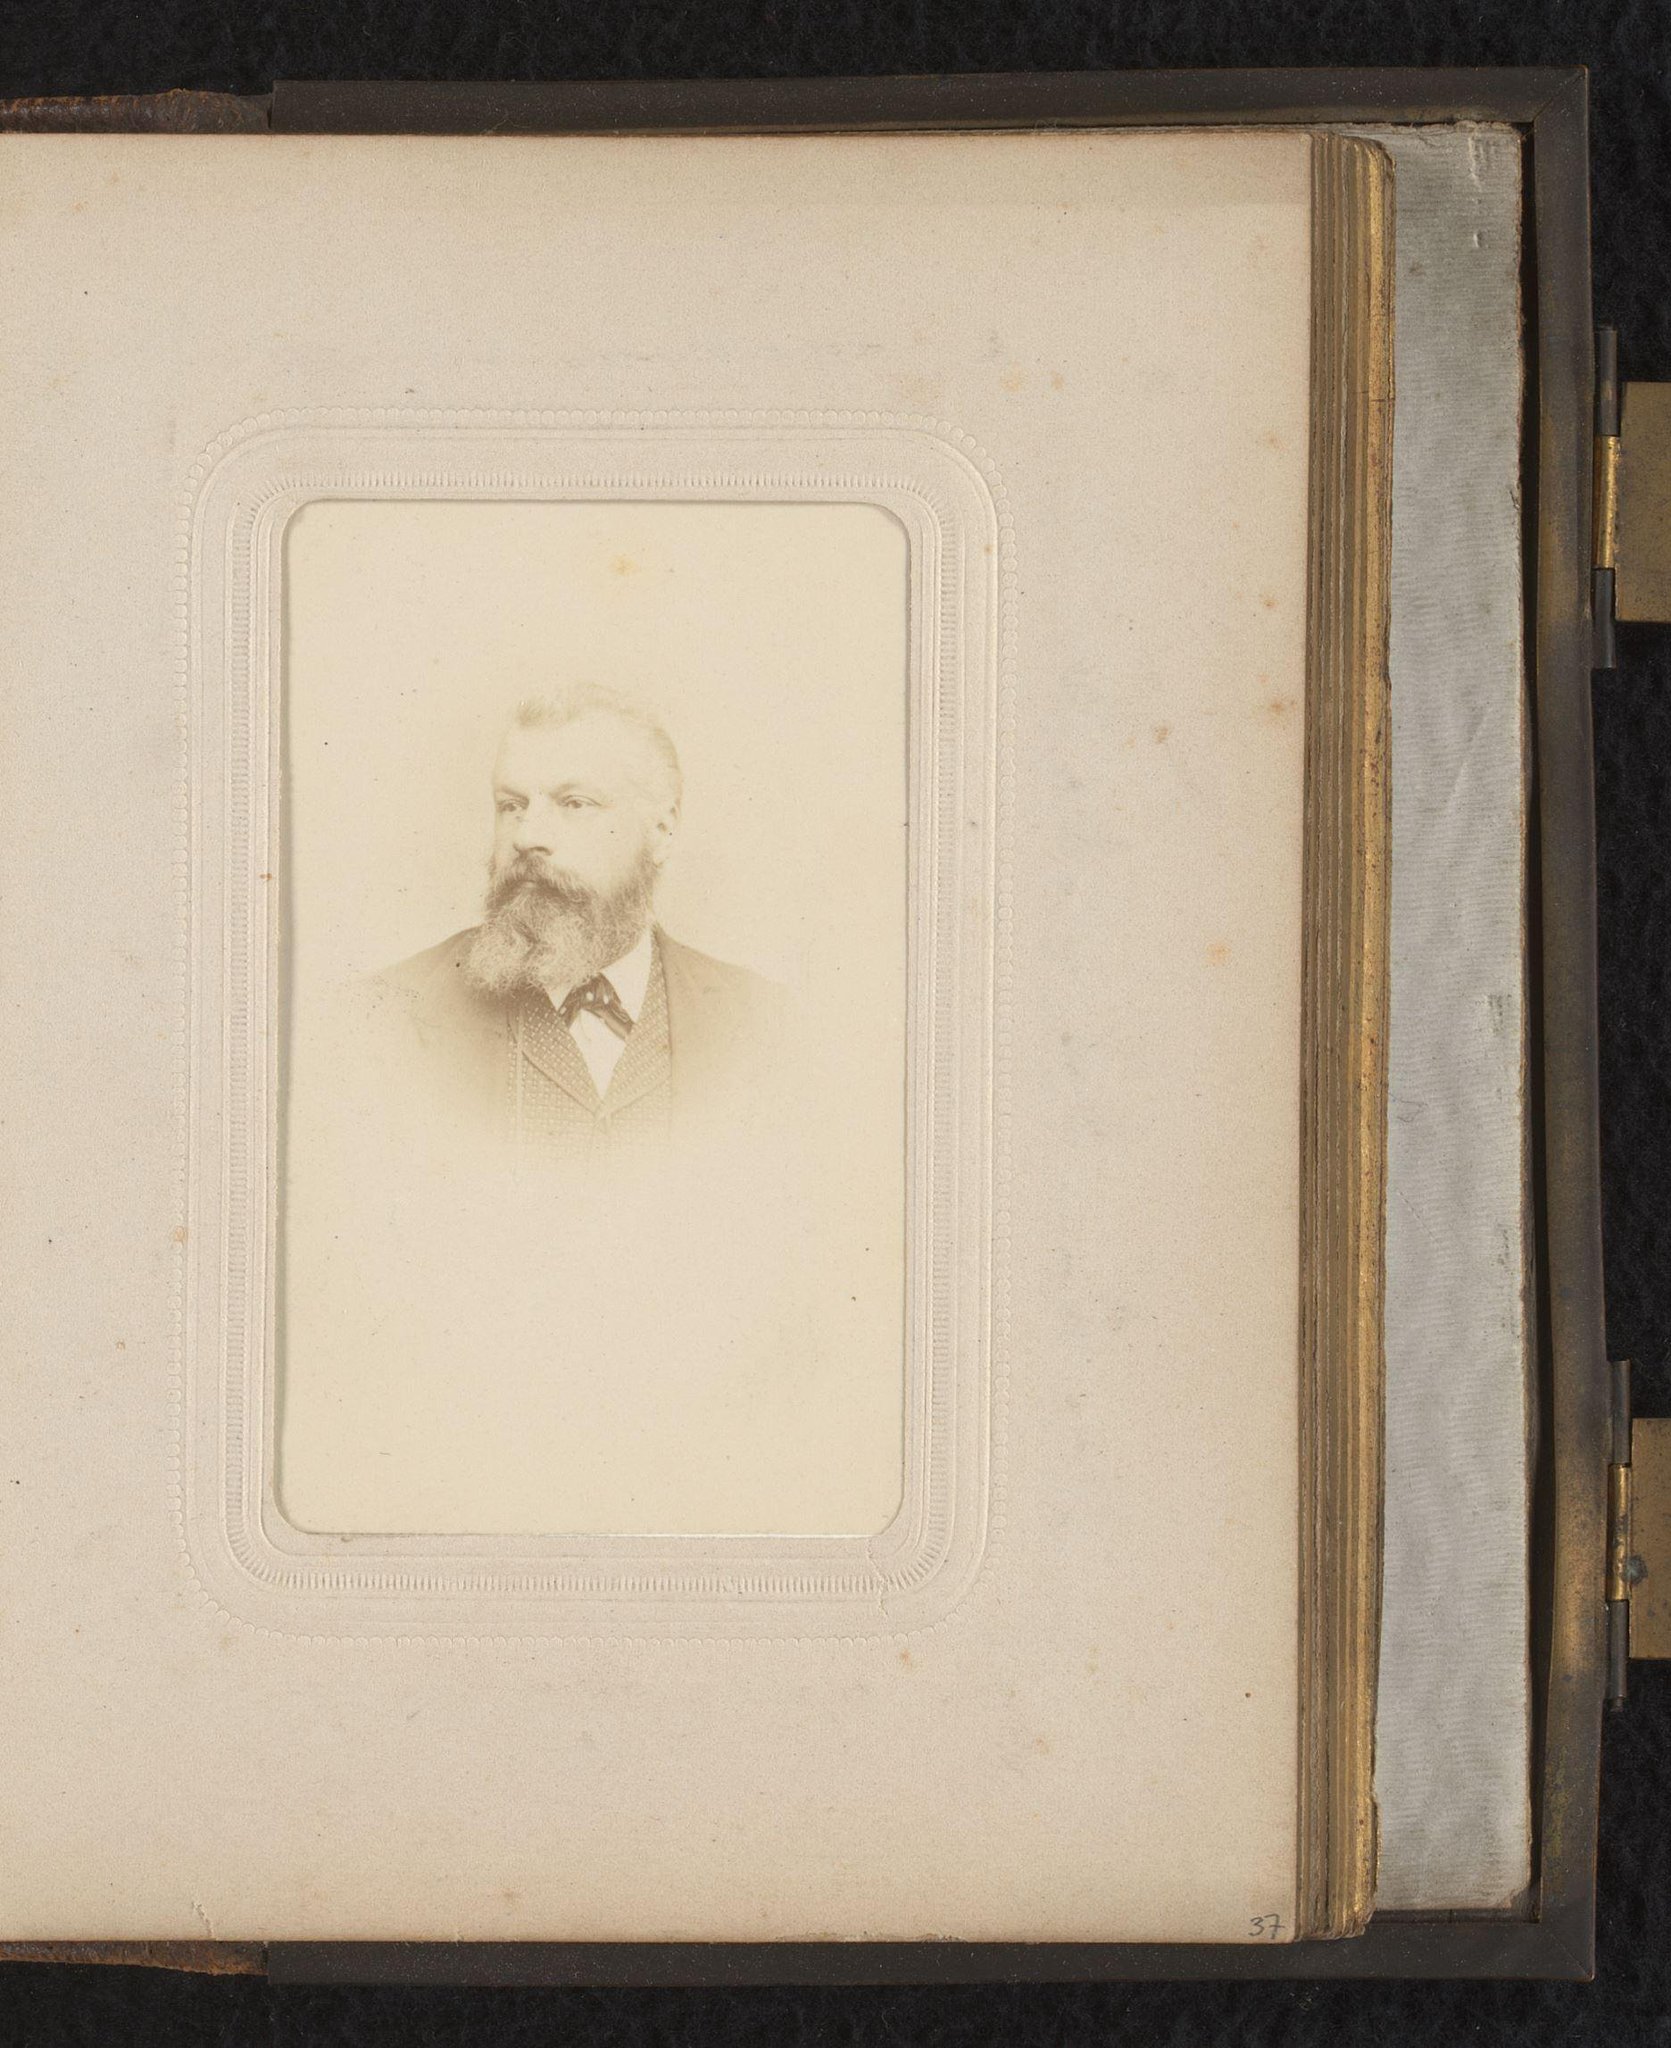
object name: carte de visite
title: Portret van een man met snor en baard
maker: théodore saglio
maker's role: fotograaf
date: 1860-1900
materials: cardboard, photographic support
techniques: albumen print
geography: paris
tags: moustache, historical persons, beard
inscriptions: inscription: ‘Photographie Alsacienne/ ANCIENNE MAISON/ ERWIN./ THÉODORE SAGLIO/ SUCCESSEUR/ 4, Rue Frochot, 4/ (Quartier St. Georges)/ PARIS.’